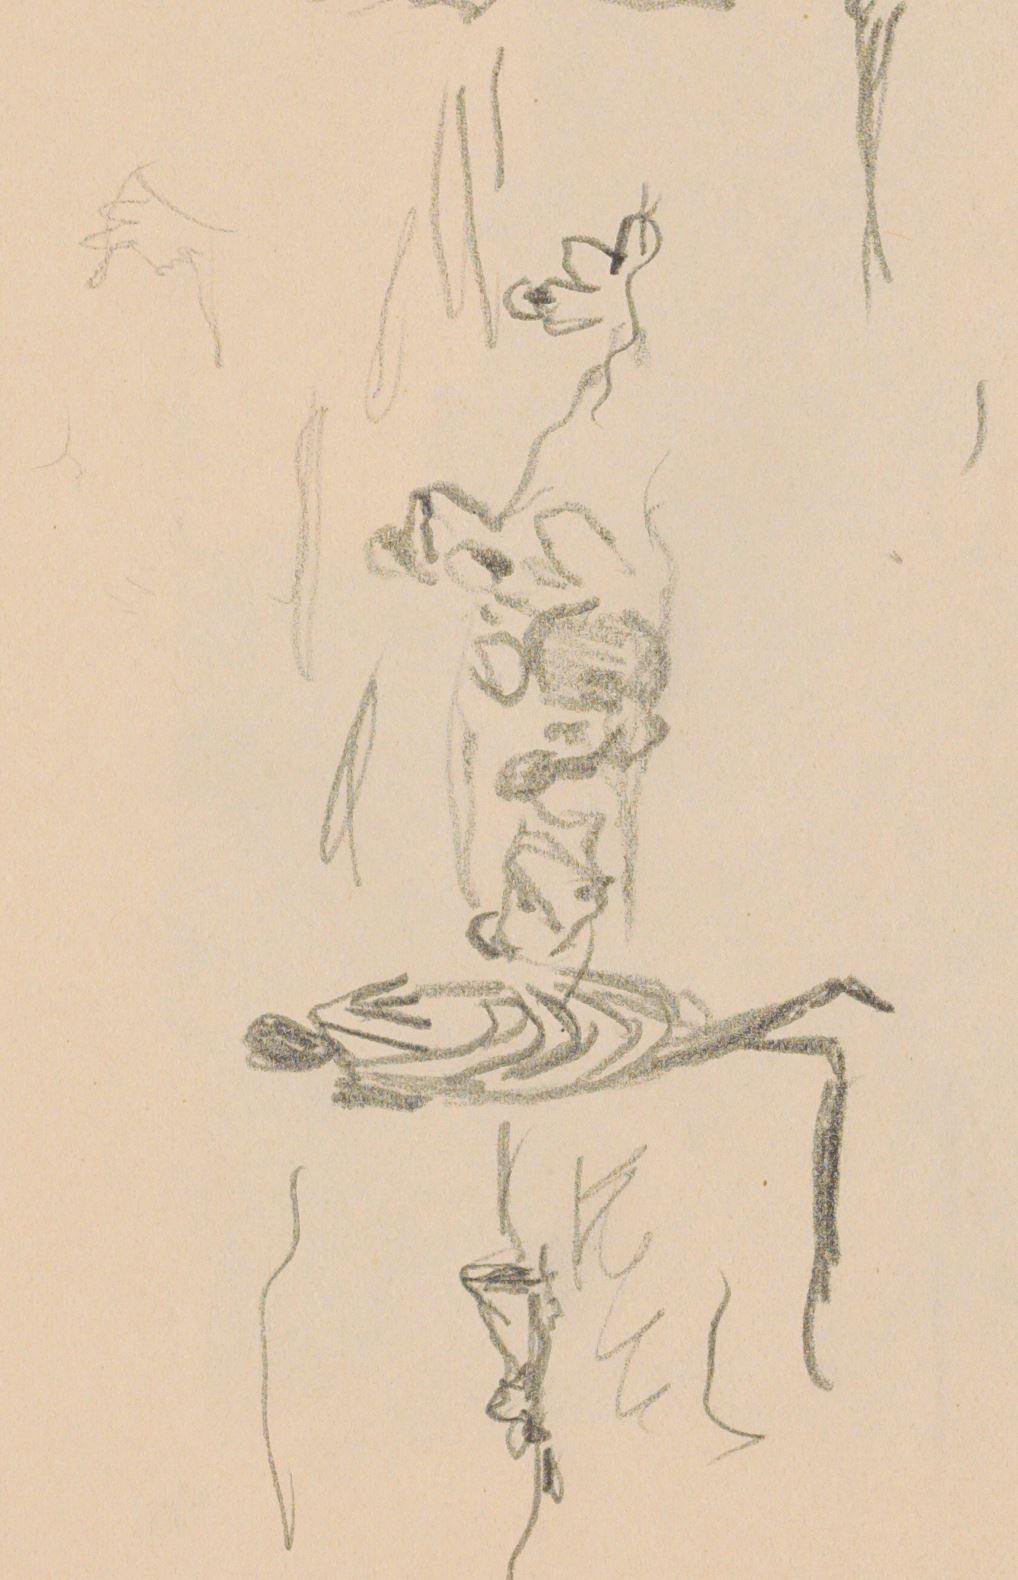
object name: sketchbook leaf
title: Landschap met Indiërs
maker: marius bauer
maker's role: draughtsman, print maker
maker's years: 1867-1932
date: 1924-1925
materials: paper, pencil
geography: india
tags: sitting figure, walking, landscapes (+ landscape with figures, staffage), asiatic races and peoples: indians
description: Een aantal figuren zit in een groep. Op de voorgrond twee lopende figuren. Pagina 13 uit een schetsboek met 87 bladen.